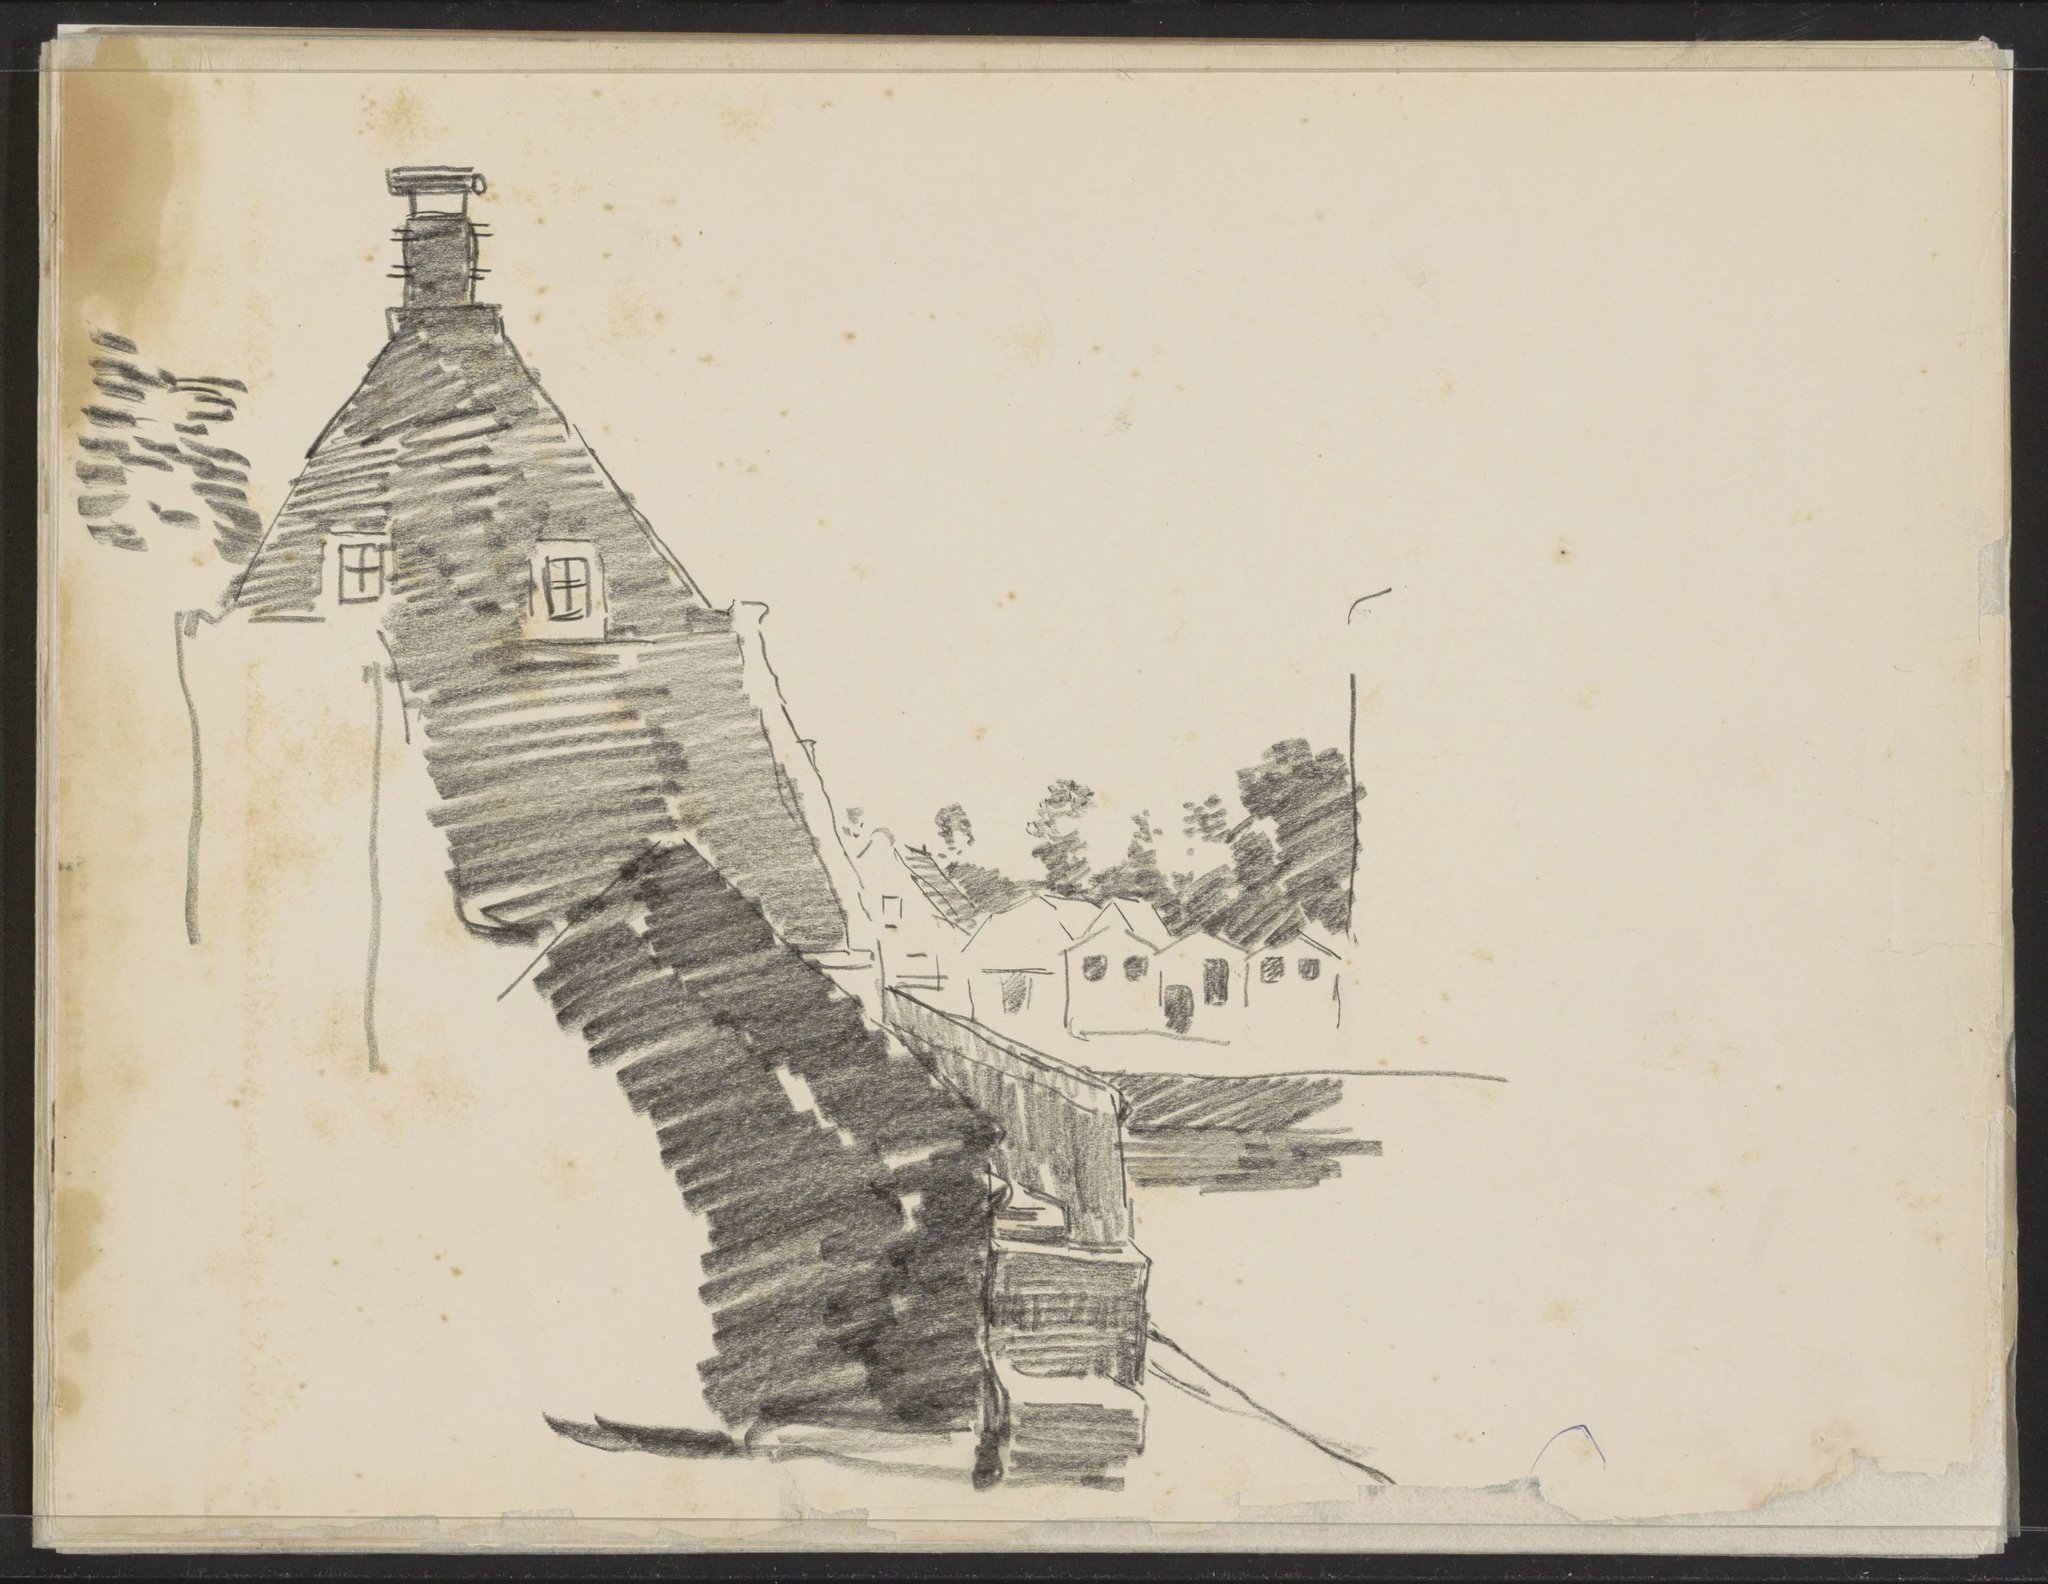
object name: sketchbook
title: Schetsboek met 28 bladen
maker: willem bastiaan tholen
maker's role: draughtsman, painter, print maker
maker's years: 1860-1931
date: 1870-1931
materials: chalk, paper, pencil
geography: scheveningen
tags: trees, landscapes, landscapes with waters, waterscapes, seascapes (in the temperate zone), rural housing, e.g. country-house, villa, cottage, ships (in general)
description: Schetsboek bestaande uit 28 bladen met landschappen, bomen, dieren, wolken, straatgezichten, schepen en figuren.